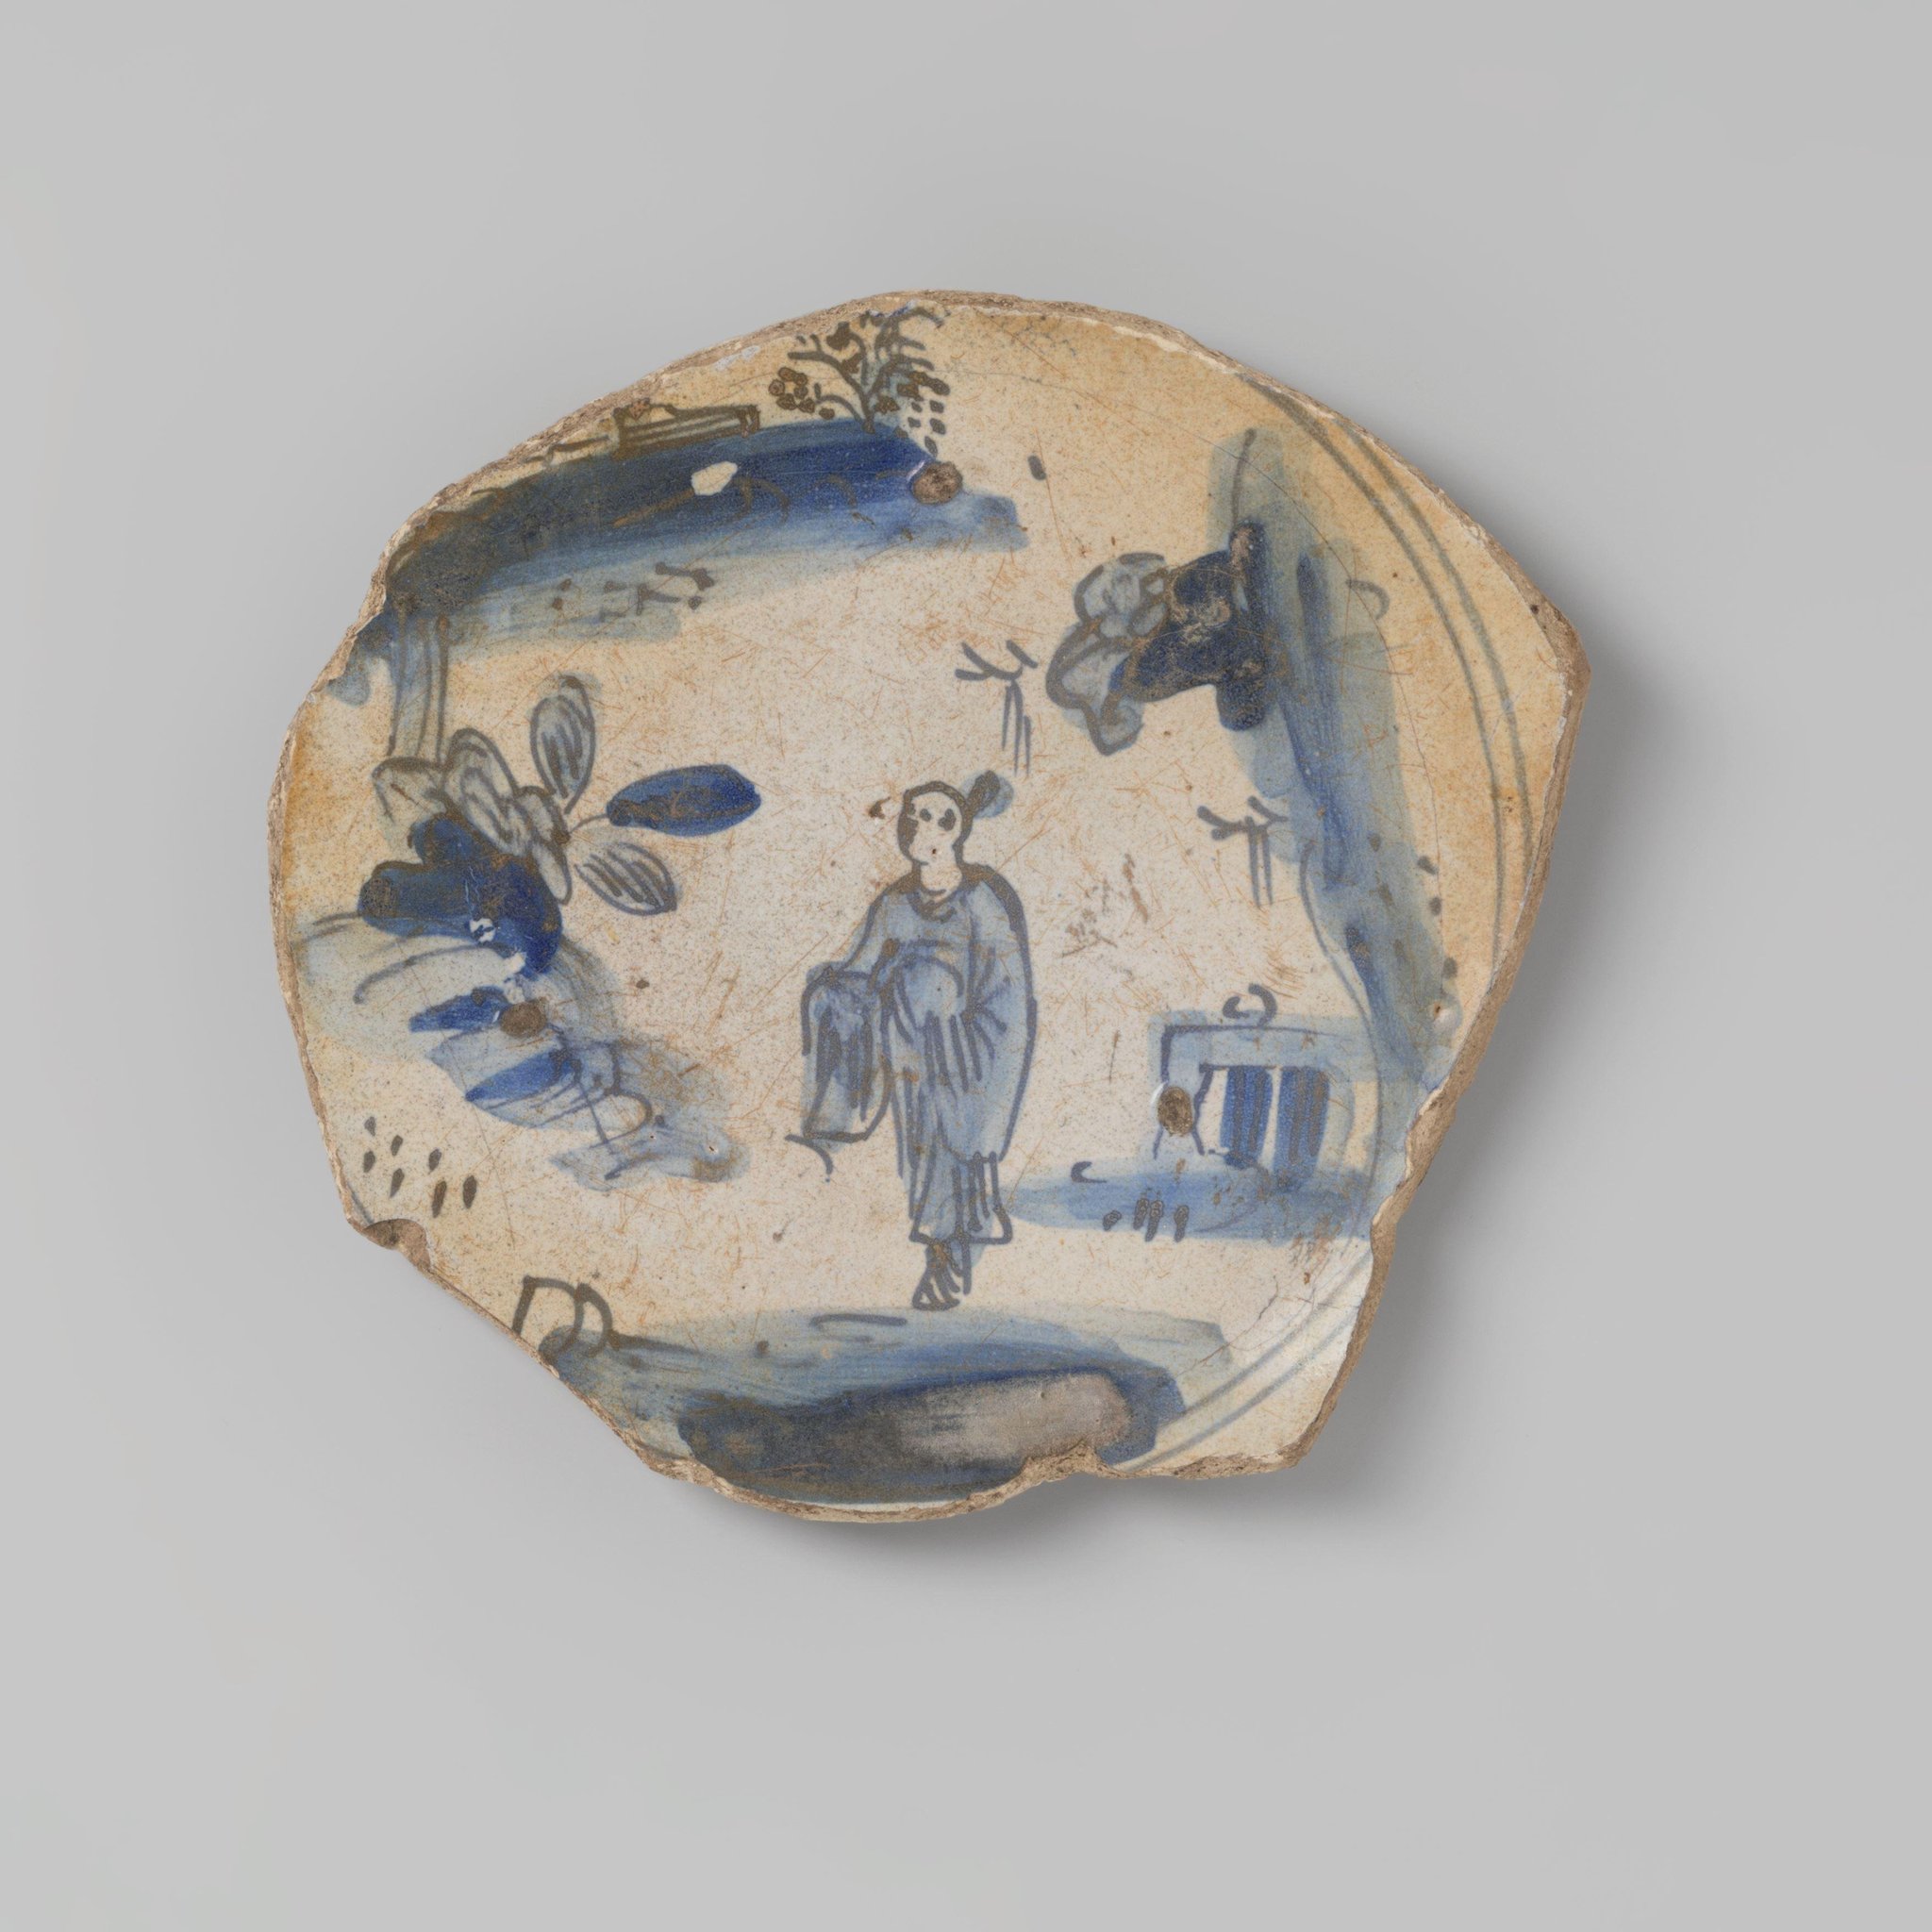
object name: sherd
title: Schotelscherf van aardewerk, voorzien van loodglazuur aan de onderzijde en aan de bovenzijde wit tinglazuur met in blauw een voorstelling van een persoon in kimono in een landschap, beschadigd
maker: Anonymous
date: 1500-1799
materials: earthenware, glaze